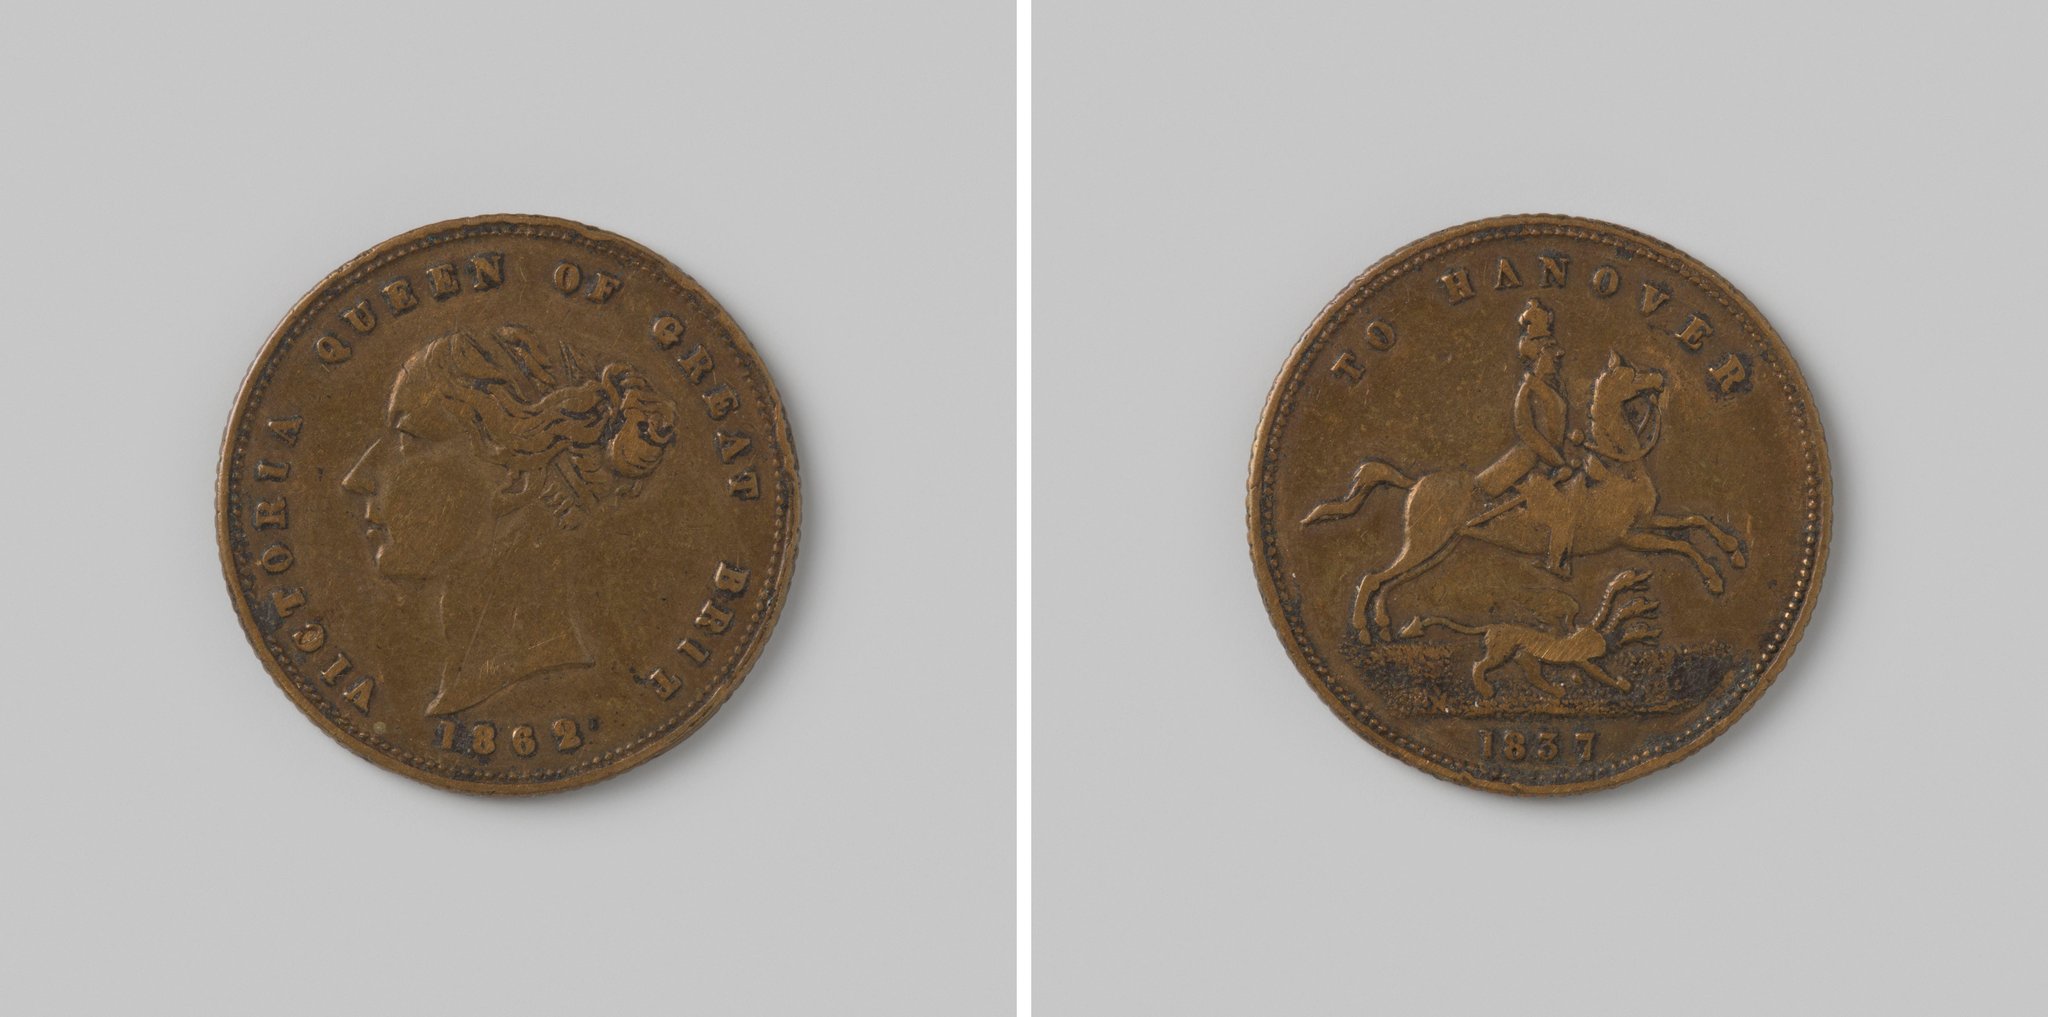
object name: history medal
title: "To Hannover" token 1837/1862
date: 1837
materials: brass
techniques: striking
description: Messing penning, op de voorzijde het portret van Koningin Victoria naar links met omschrift, op de keerzijde een gekroonde ruiter en een driekoppige draak naar rechts, met omschrift en afsnedetekst, met kartelrand.